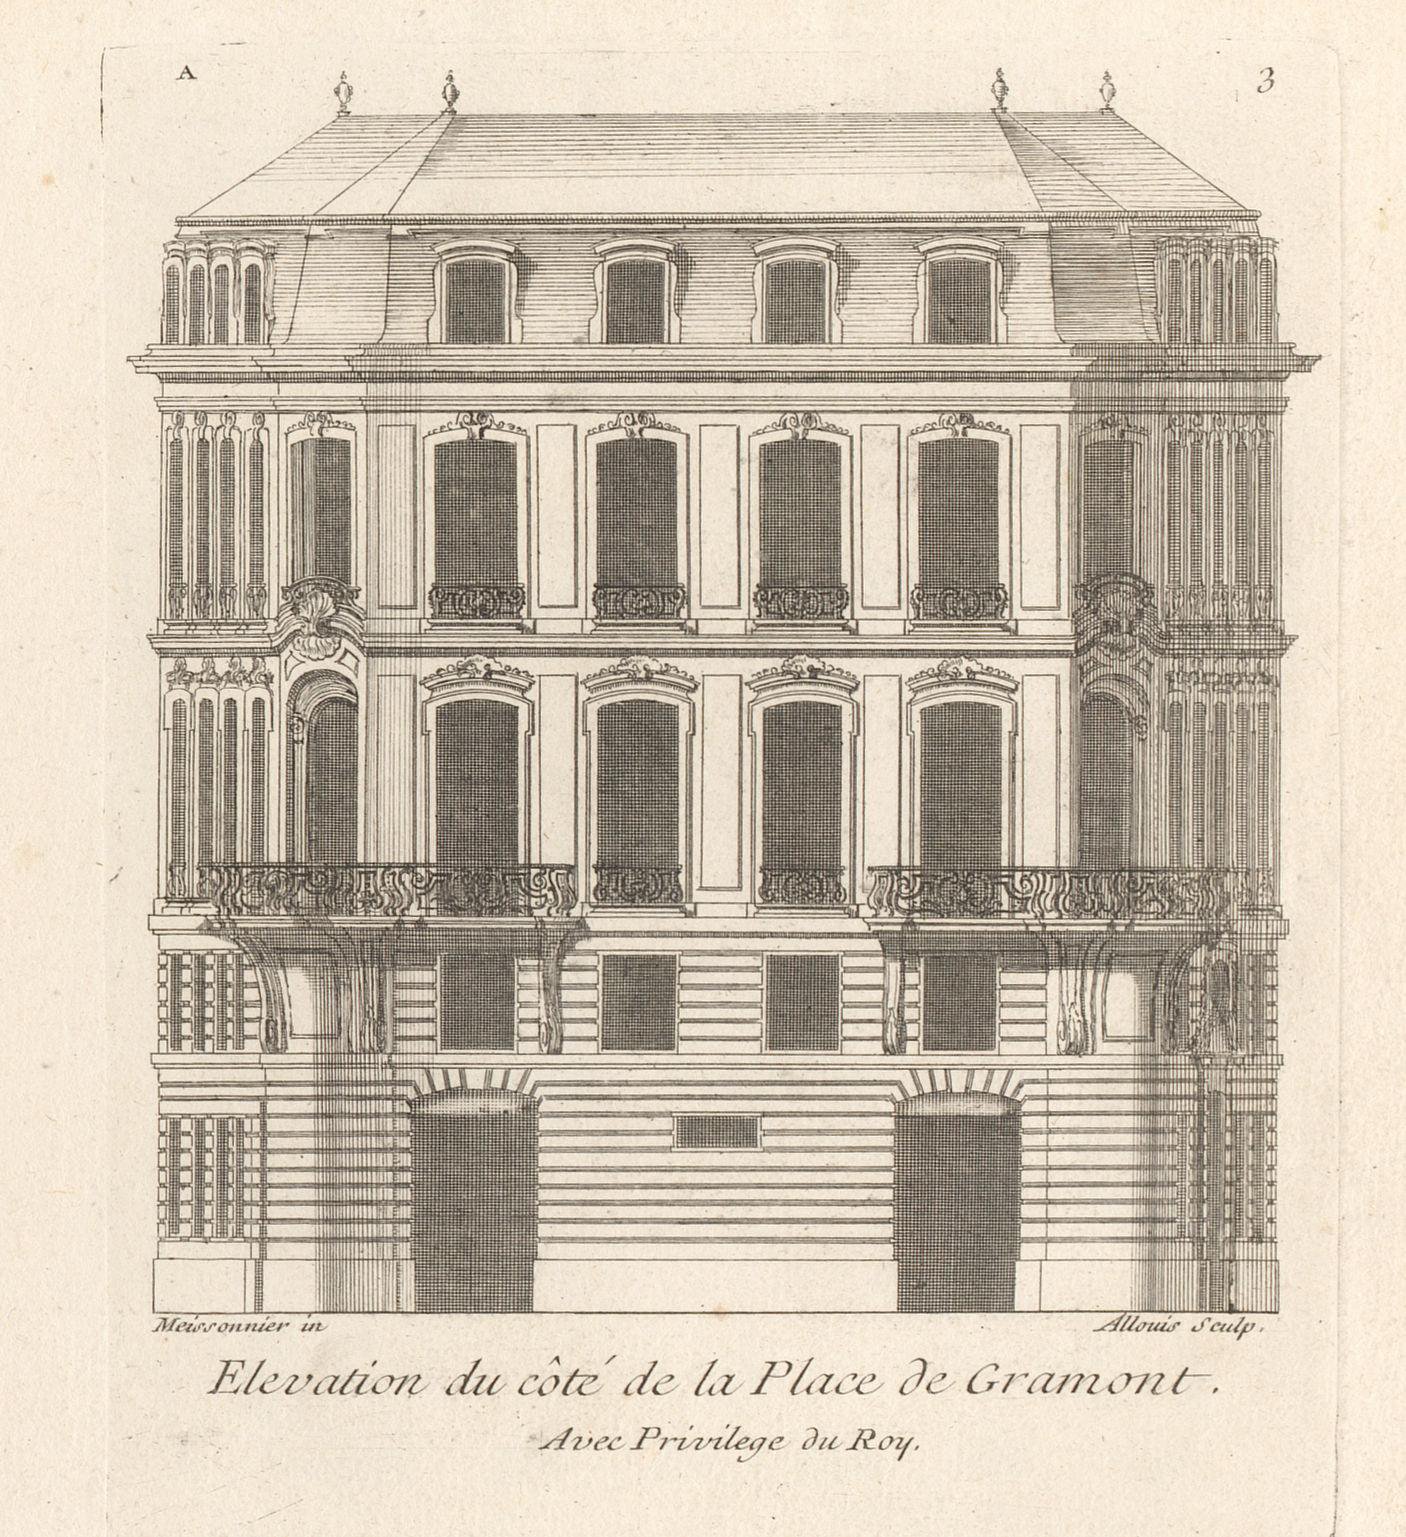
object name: album leaf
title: Maison de m. Léon Brethous a Bayonne, plans, élévations et coupes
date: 1738-1749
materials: paper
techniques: etching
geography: paris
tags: exterior ~ representation of a building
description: Prent uit een serie van elf etsen met architectuurontwerpen en plattegronden van dit huis. Deze prent maakt deel uit van een album.